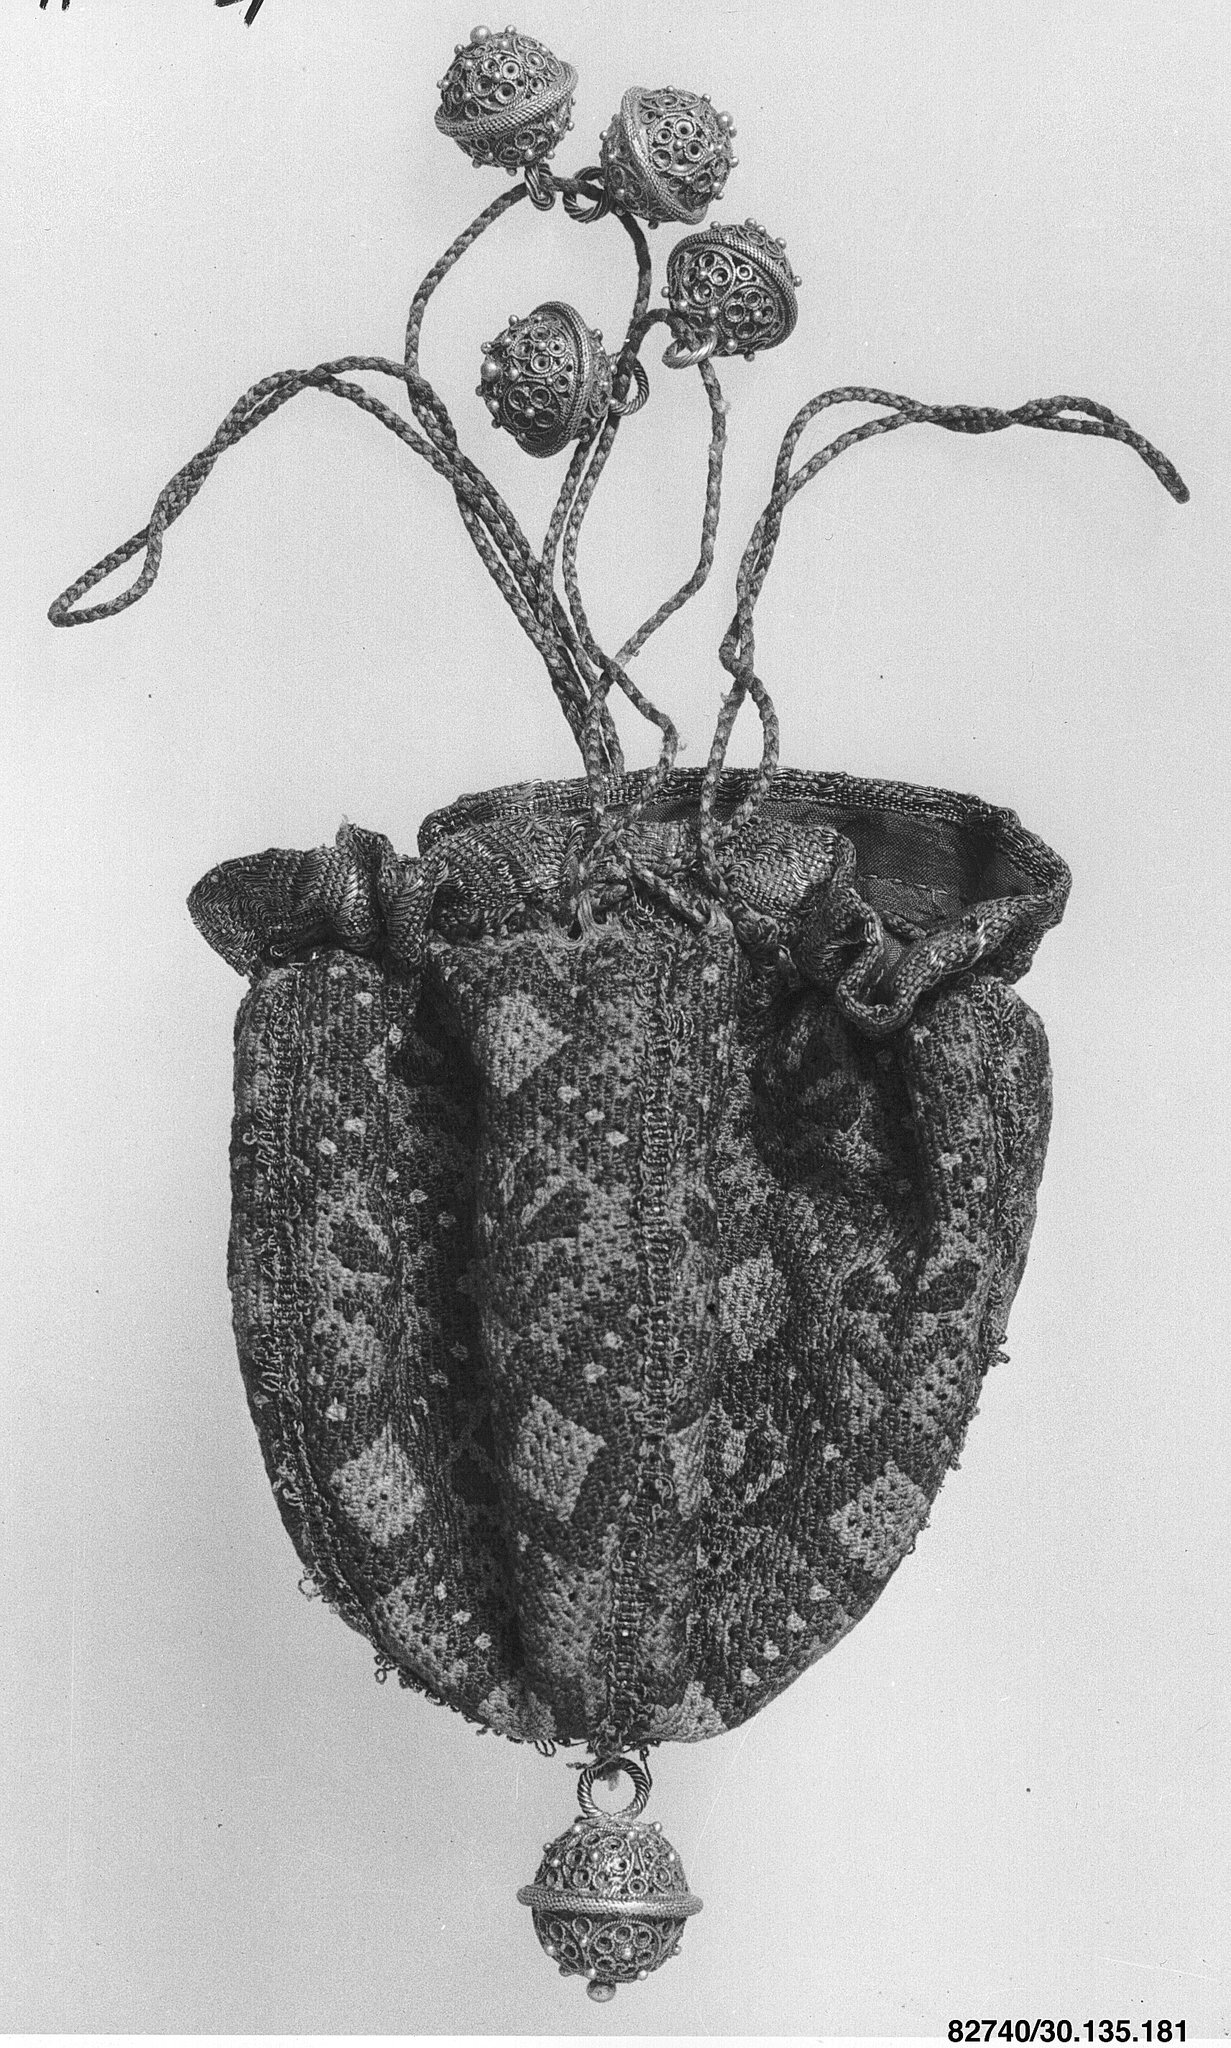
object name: bag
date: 1601-1700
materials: canvas, silk